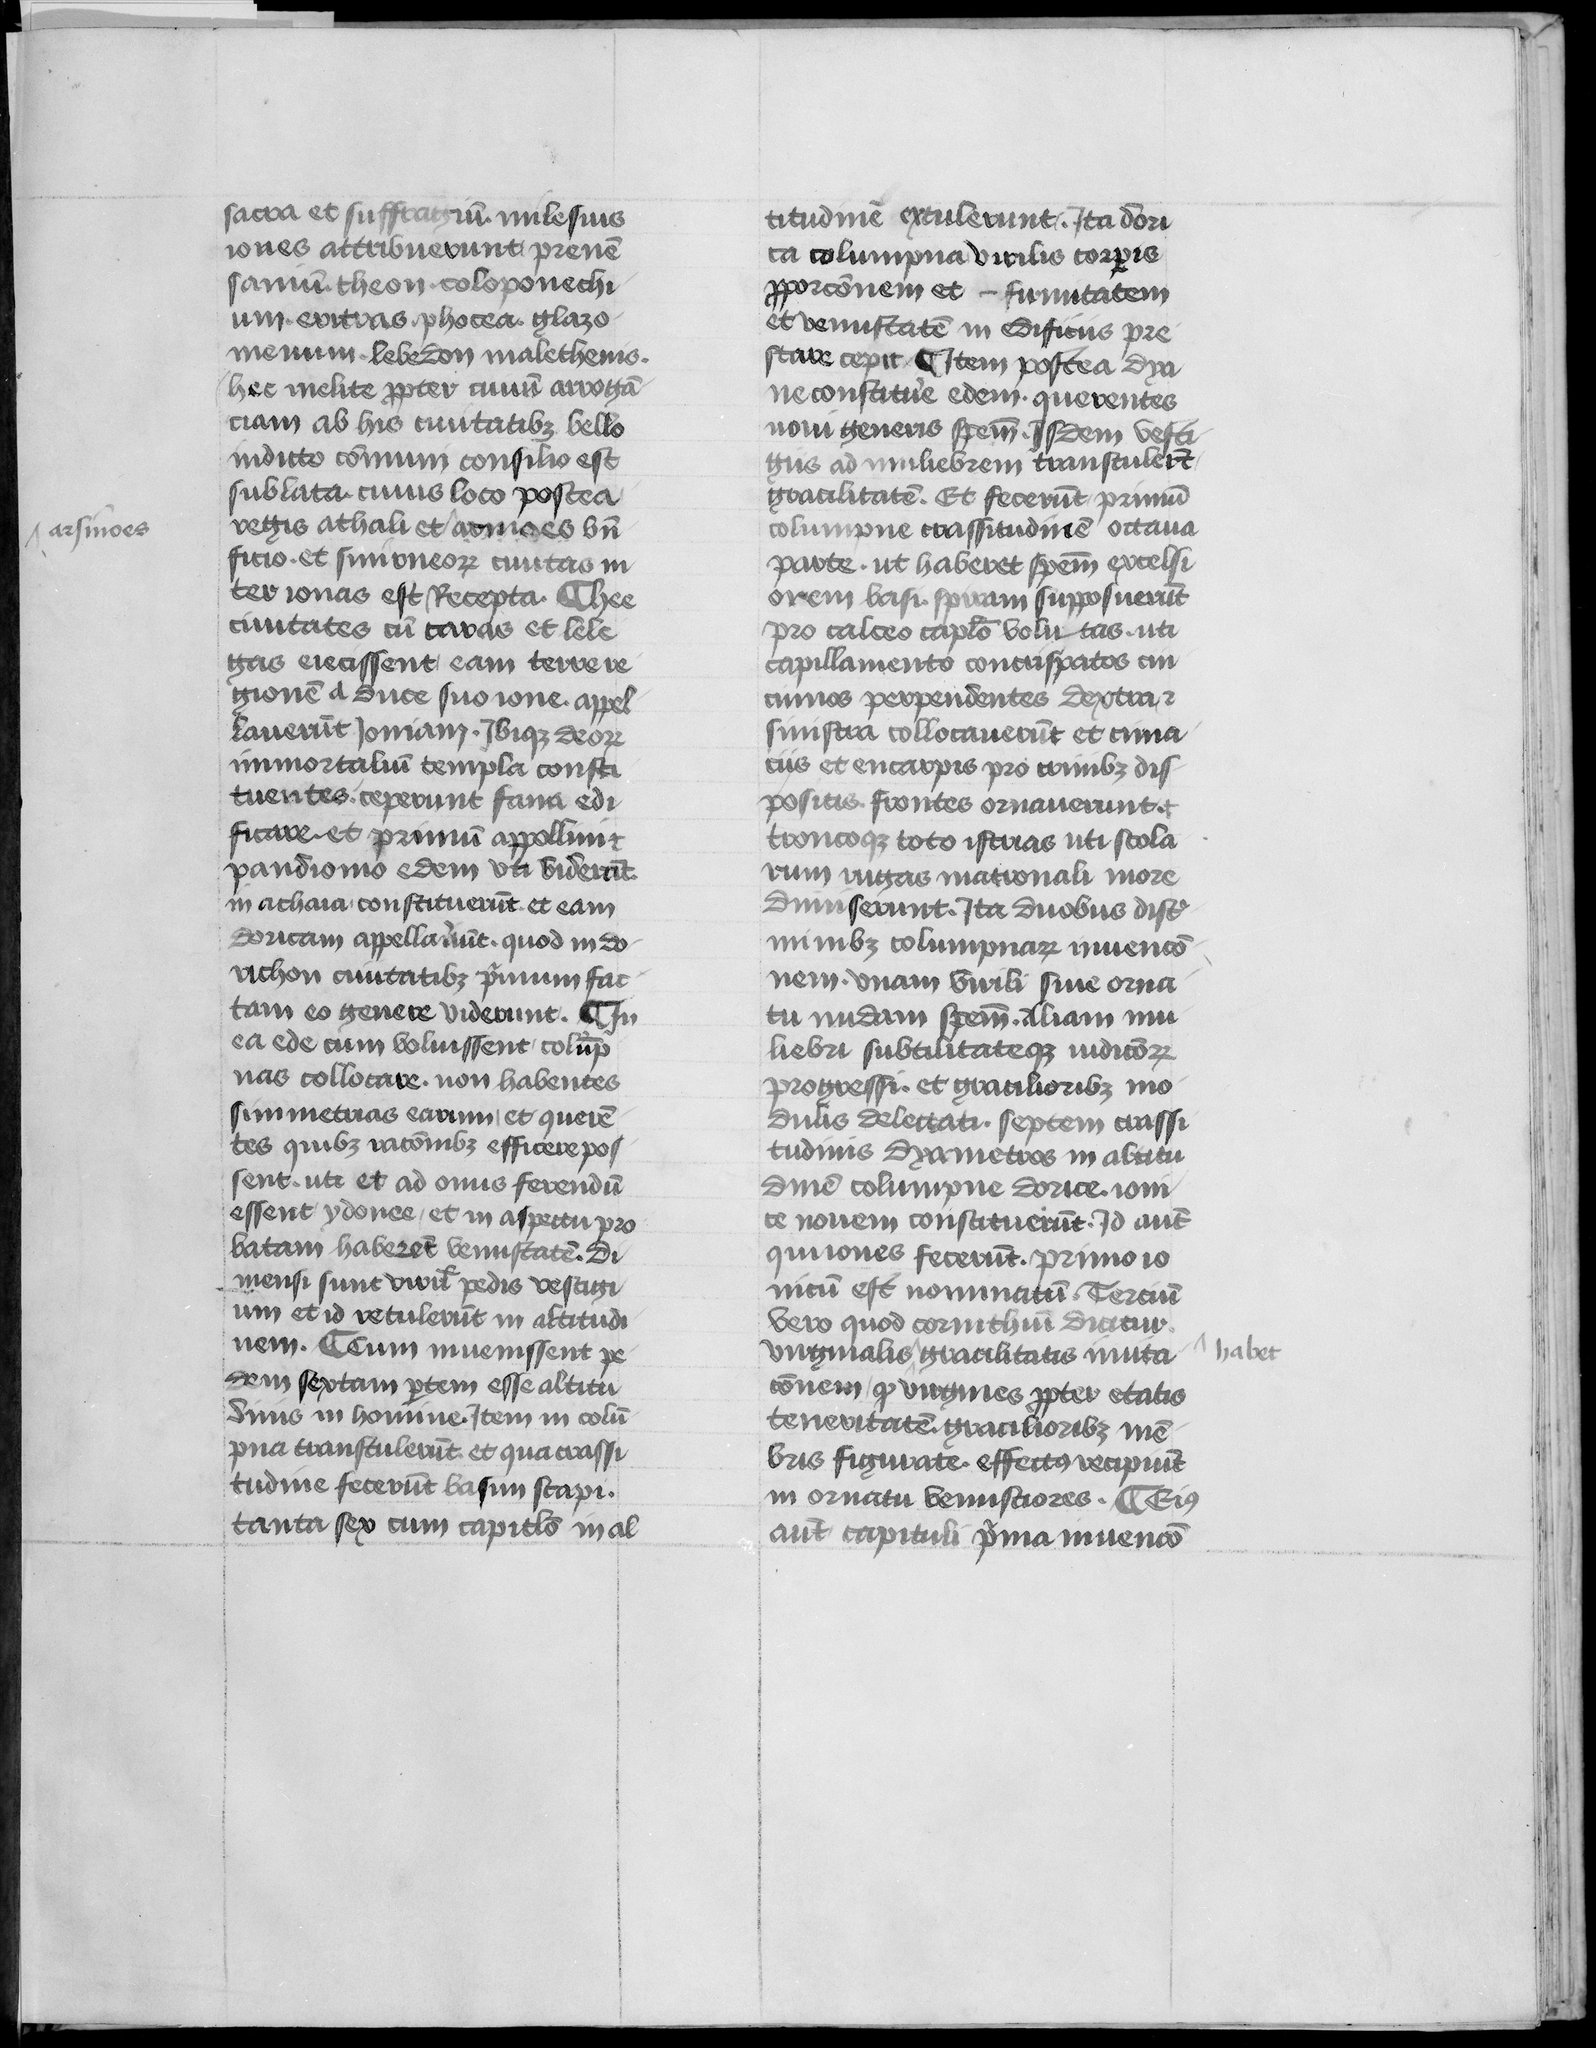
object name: book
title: De architectura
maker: marcus pollio vitruvius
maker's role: author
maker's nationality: italian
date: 1400-1450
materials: ink, pigment, parchment